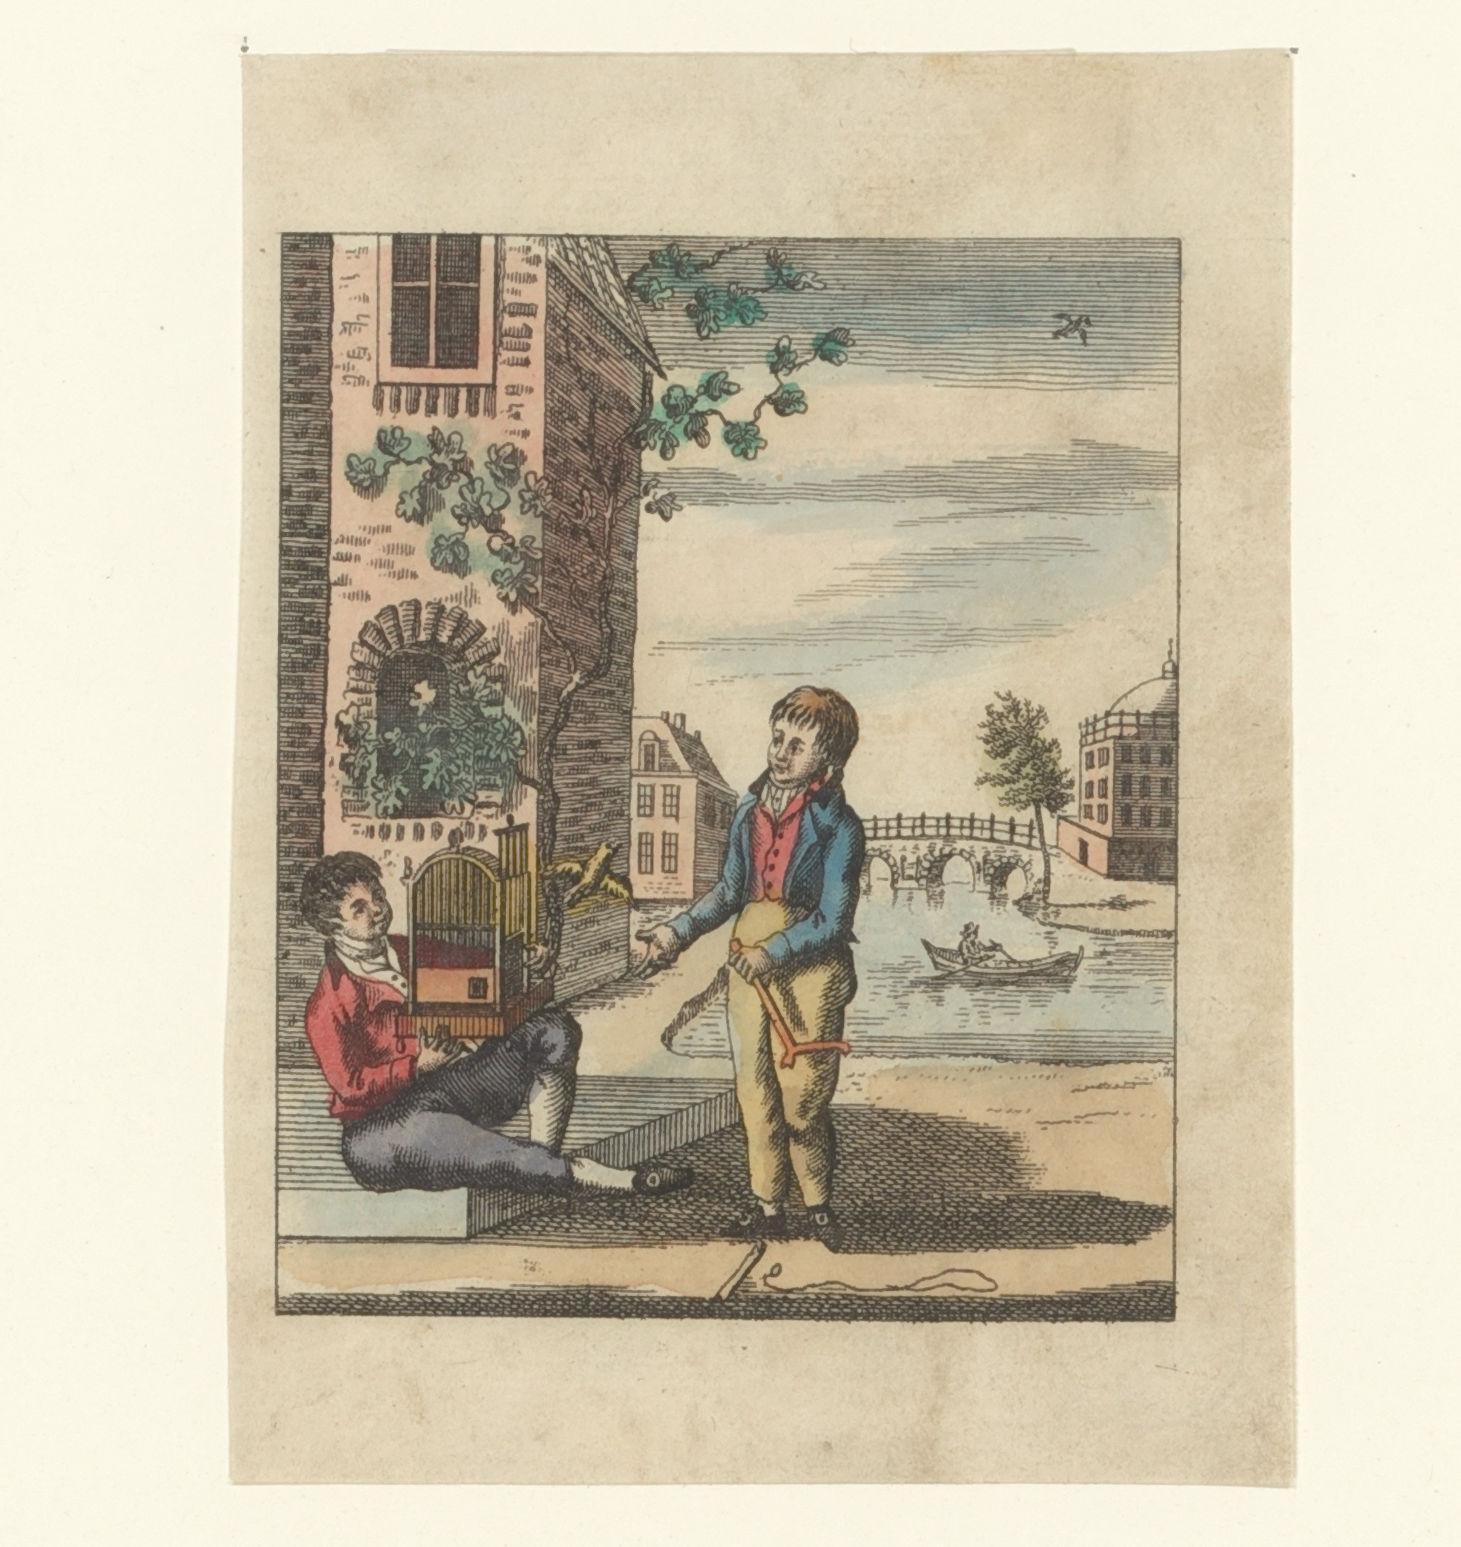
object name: print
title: Twee jongens spelen met een vogeltje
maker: Anonymous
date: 1800-1899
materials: paper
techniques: etching, hand coloring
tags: children's games and plays, birds, boy (child between toddler and youth)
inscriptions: collector's mark: Lugt 1641, stamp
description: Onderwerpsrubrieken binnen de Atlas Zeden en Gewoonten: Zeden en Gewoonten in Engeren Zin, Des menschen beging, midden en einde, Kinderleven – Kinderspel en Kinderprenten.